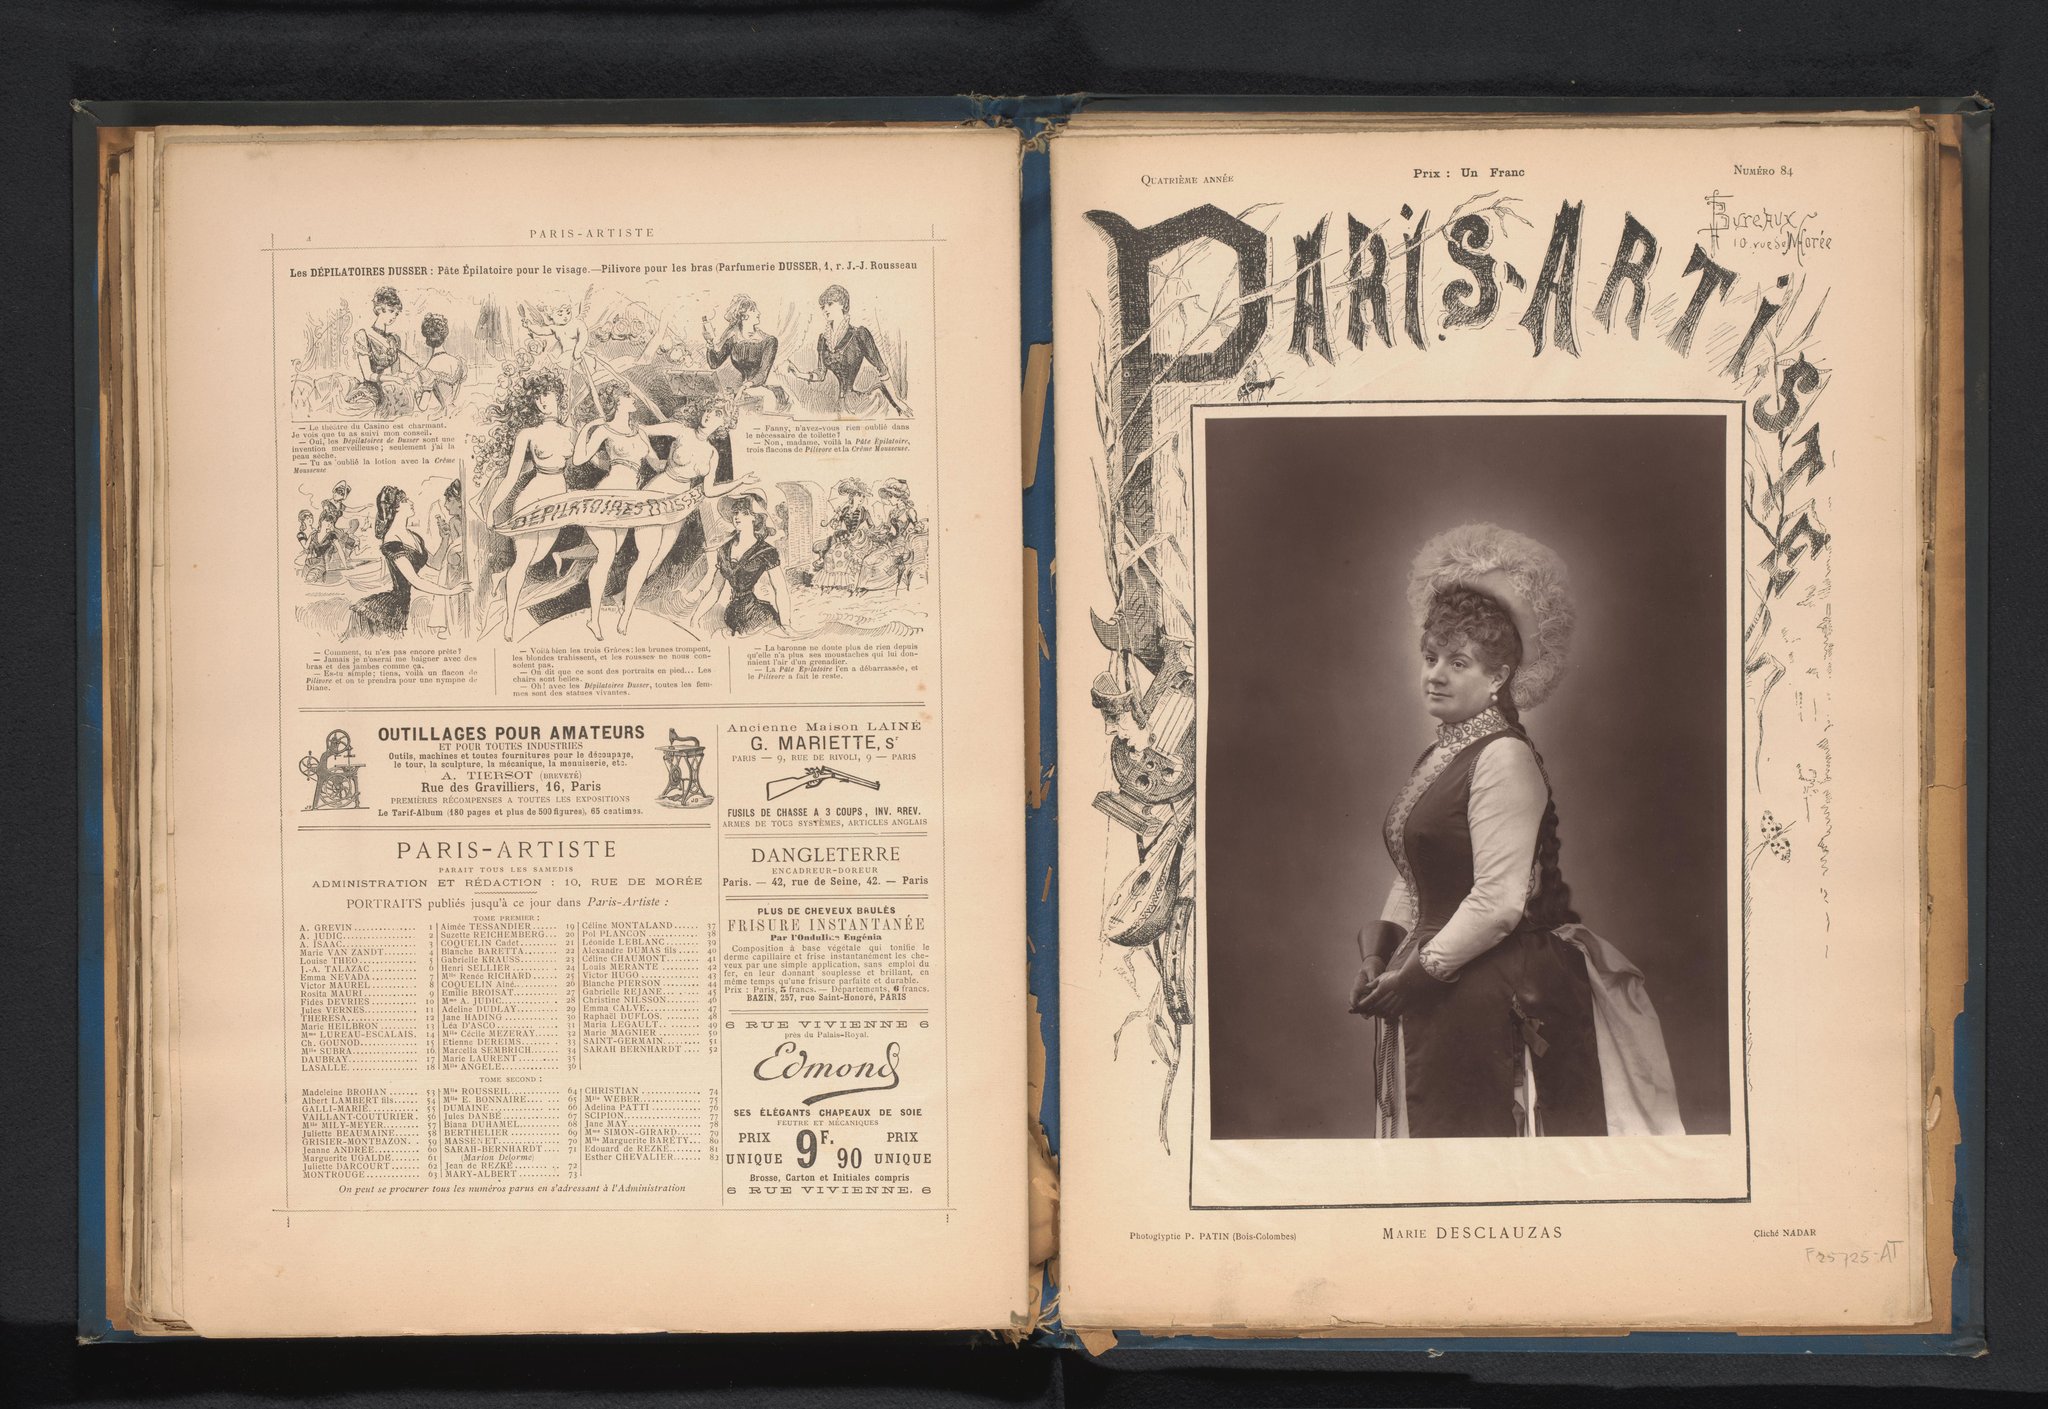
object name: photomechanical print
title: Portret van Marie Desclauzas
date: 1880-1886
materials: paper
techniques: woodburytype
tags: historical persons - bb - woman, portrait of actor, actress